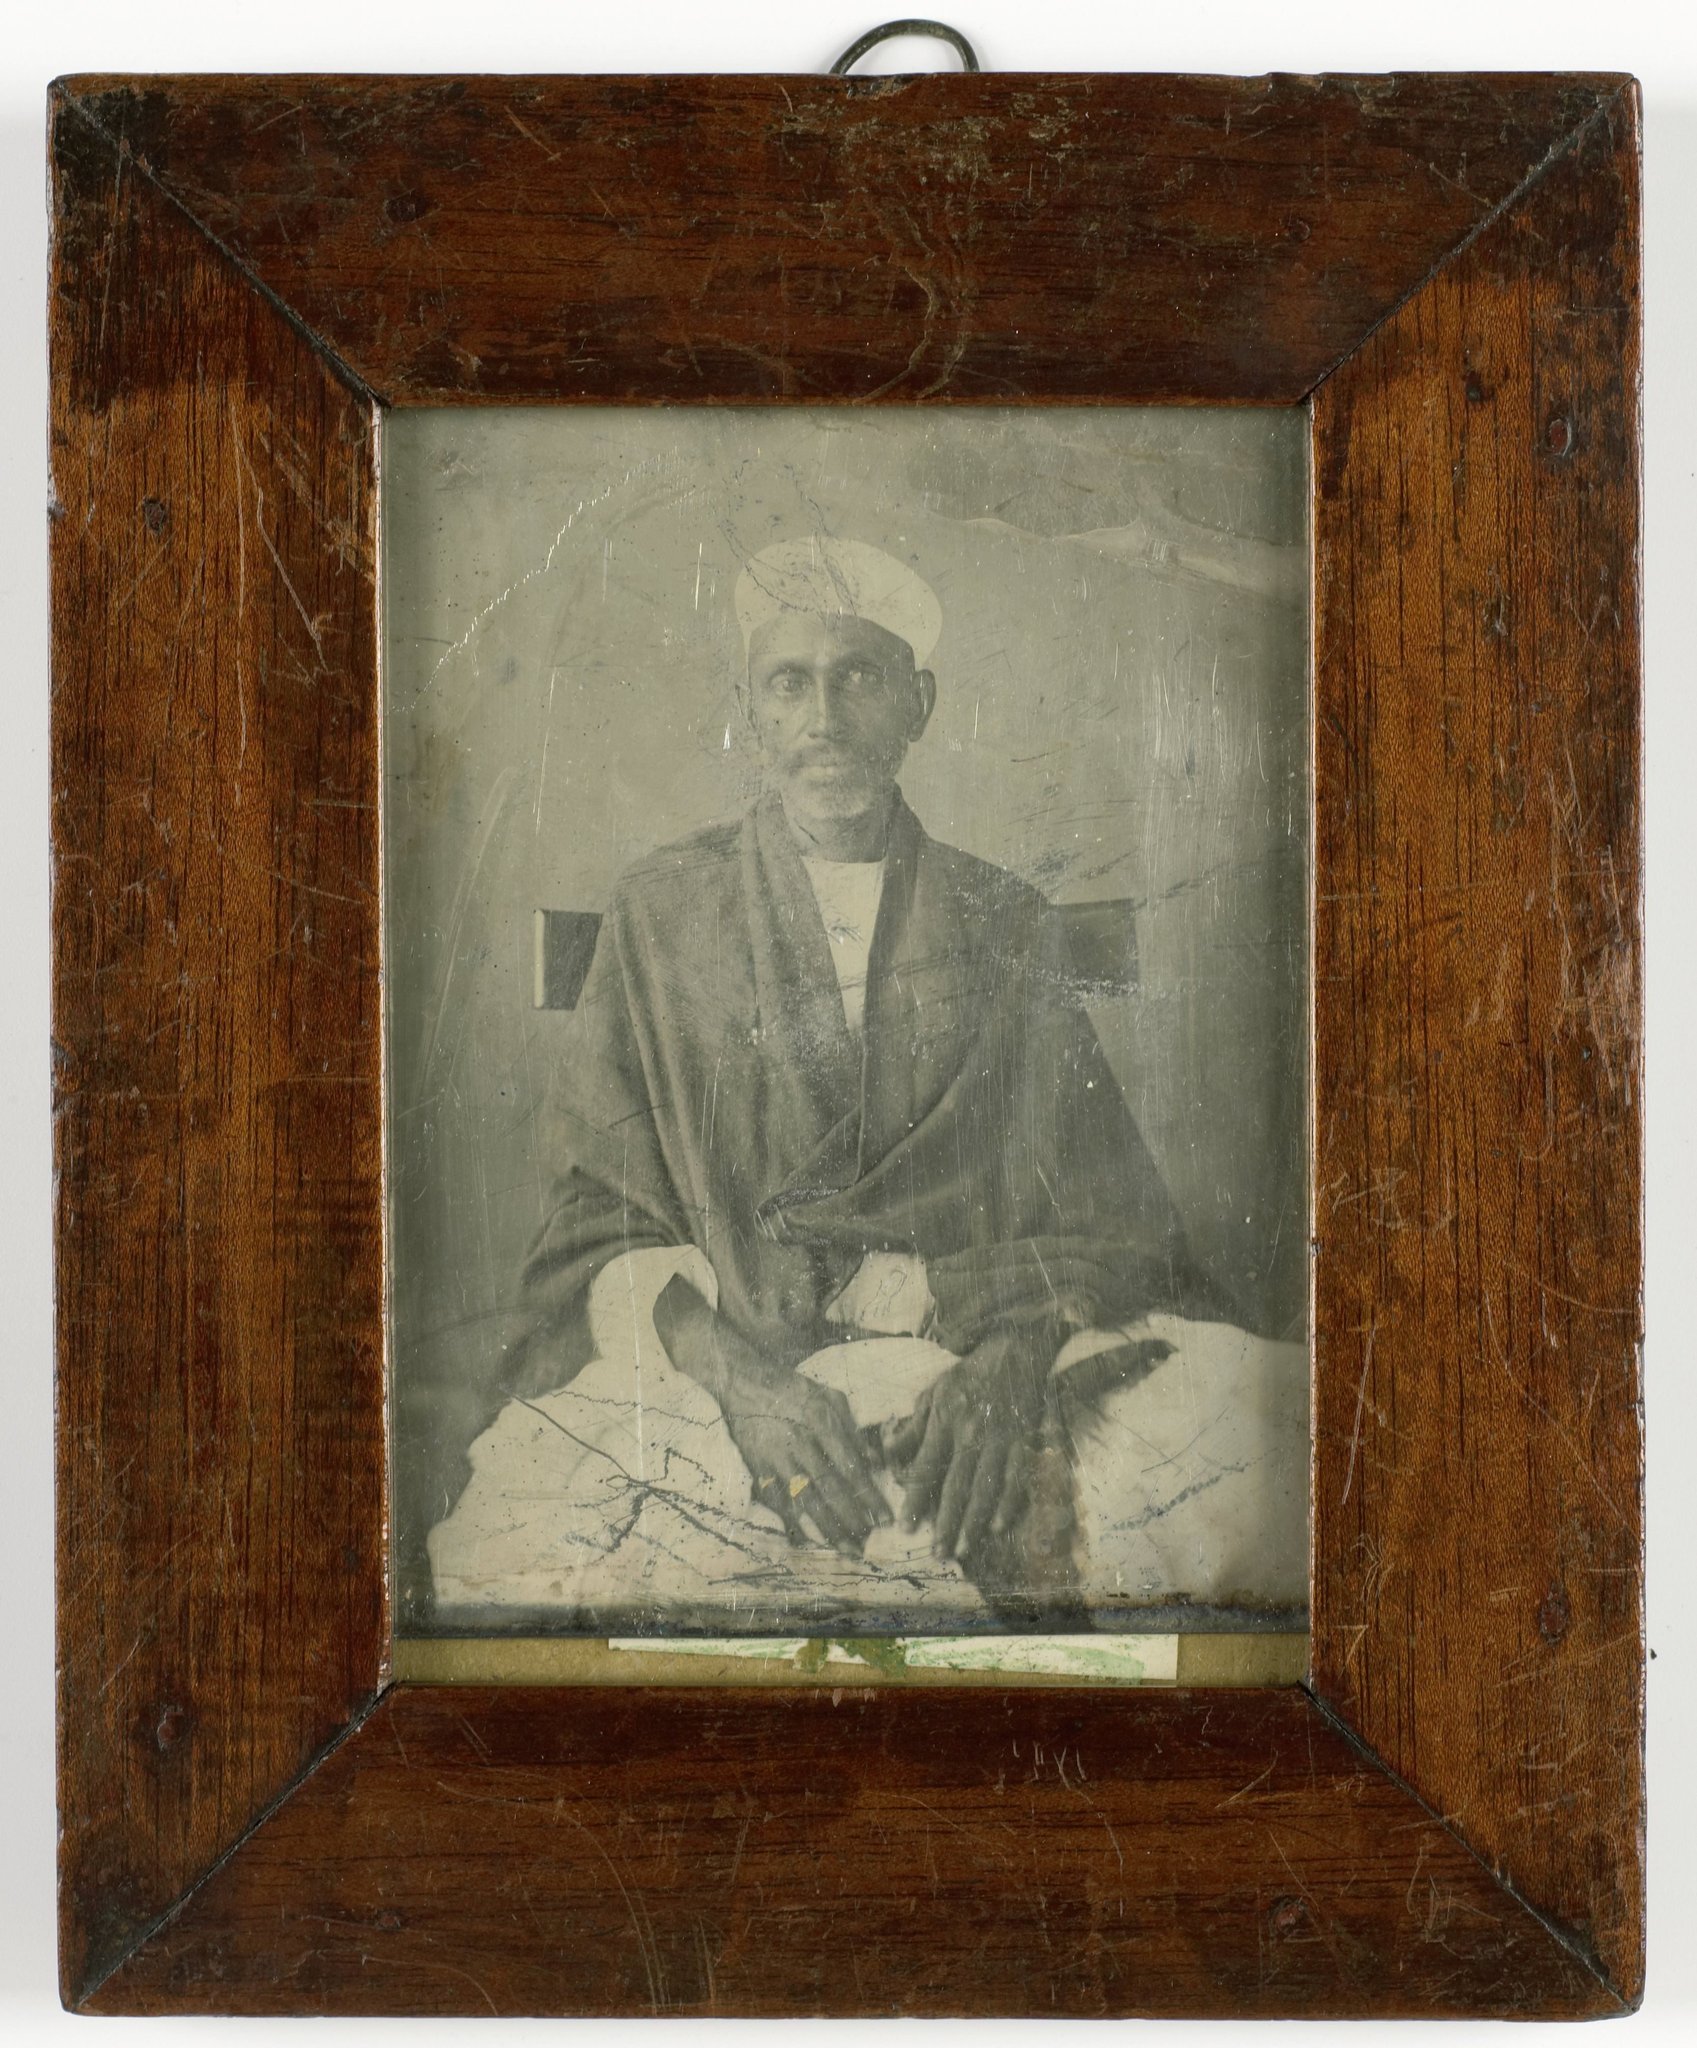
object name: photograph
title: Portret van een onbekende man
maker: Anonymous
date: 1840-1860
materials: copper, glass, wood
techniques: daguerreotype, hand coloring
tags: adult man, historical persons